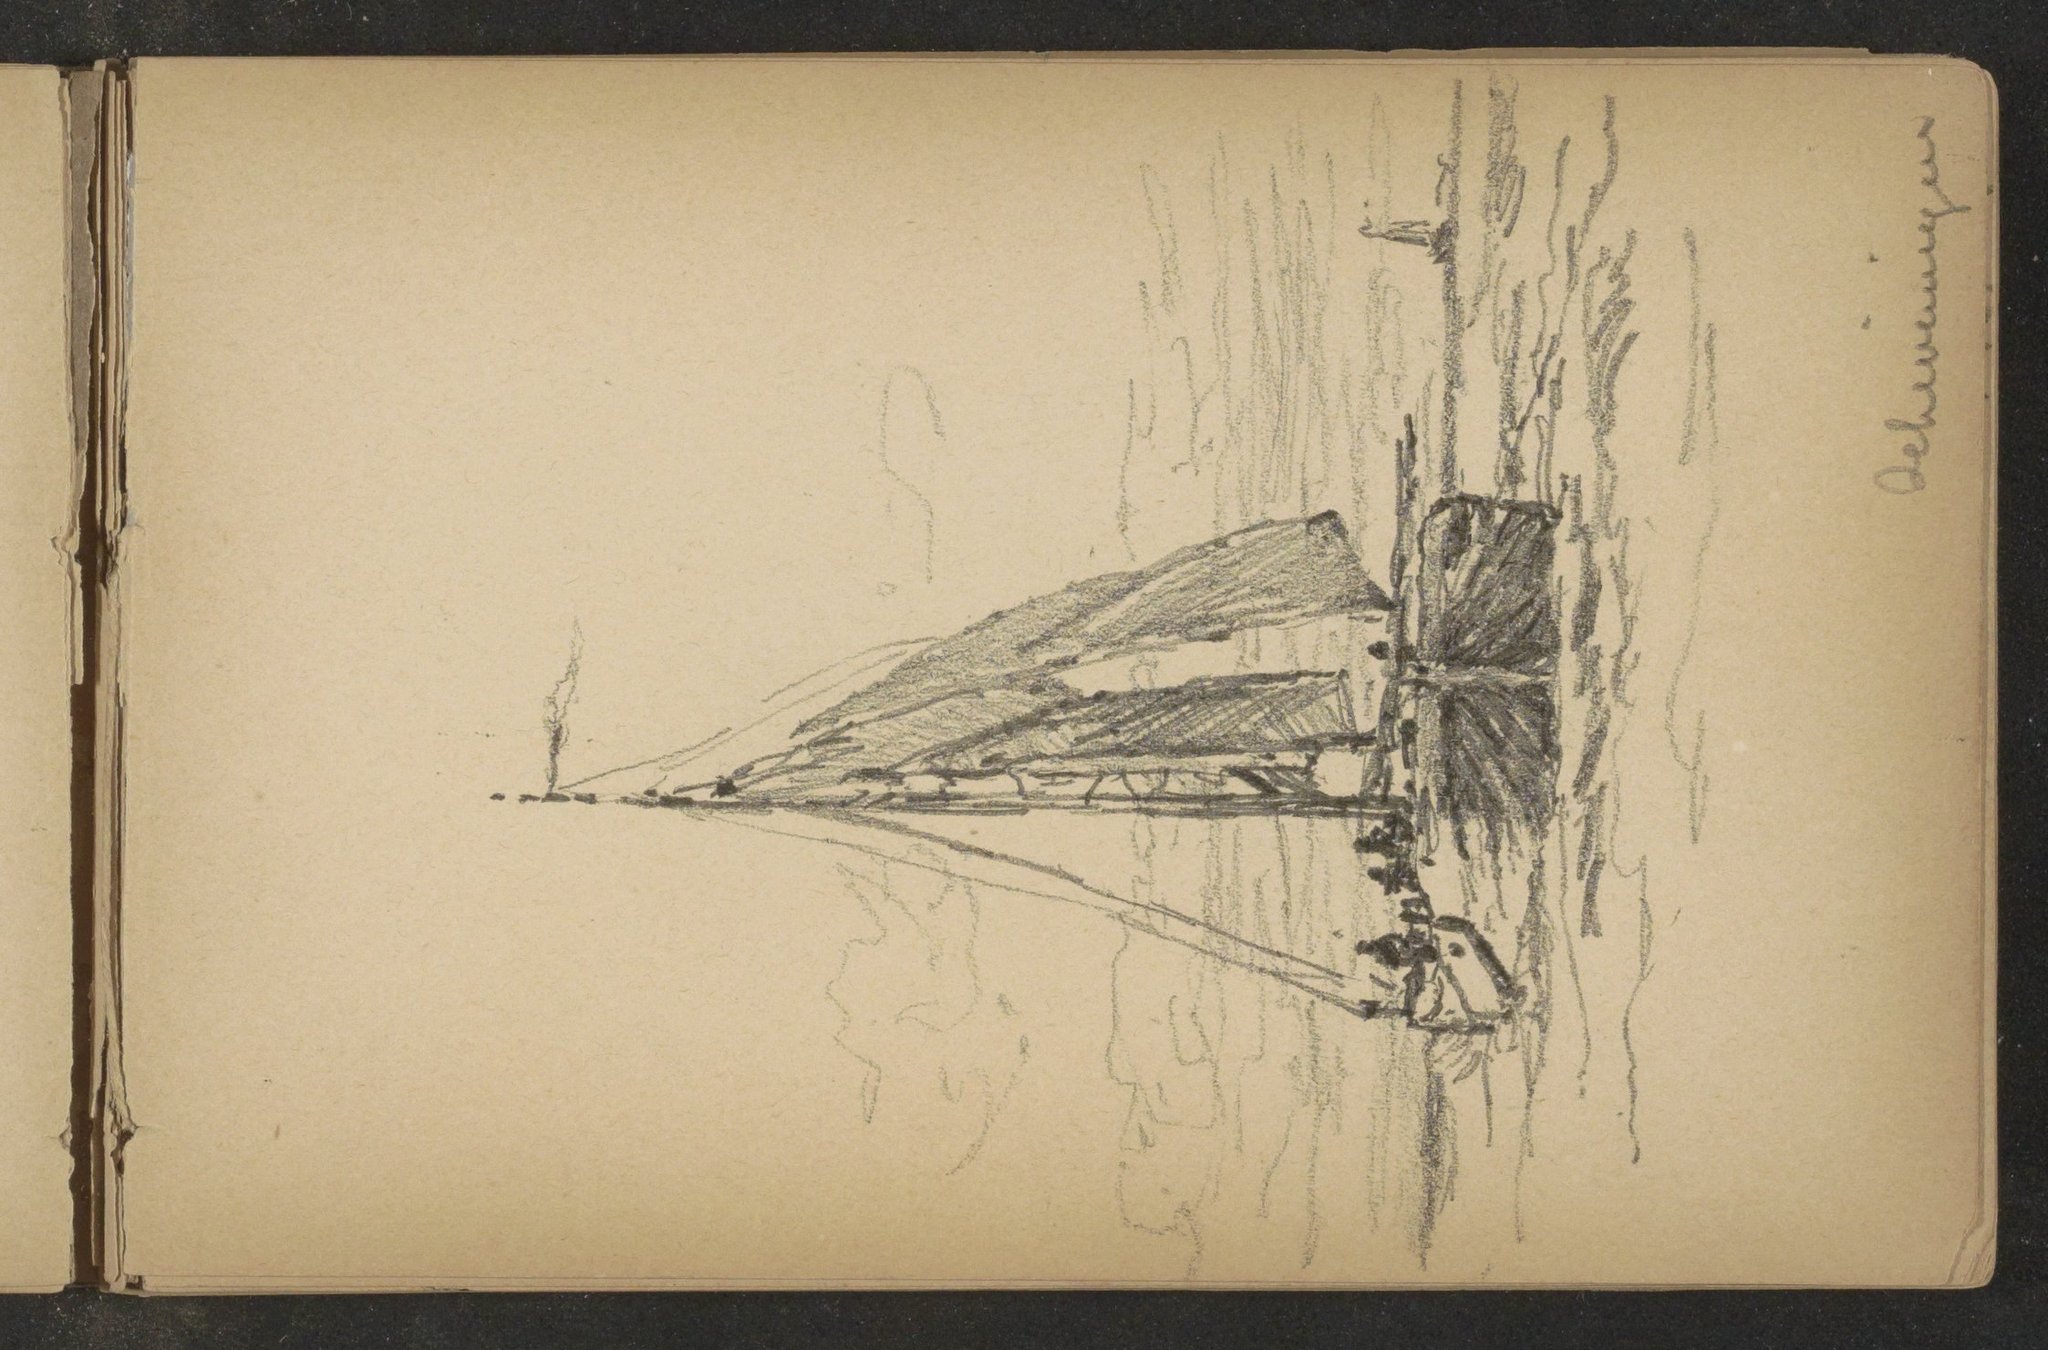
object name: sketchbook leaf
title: Figuren op een bomschuit voor de kust van Scheveningen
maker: alexander shilling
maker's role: draughtsman, print maker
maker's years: 1859-1937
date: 1809-1888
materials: paper, pencil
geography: scheveningen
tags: sailing-ship, sailing-boat, coast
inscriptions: annotation: ‘Scheveningen’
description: Blad 7 recto uit een schetsboek met 34 bladen.